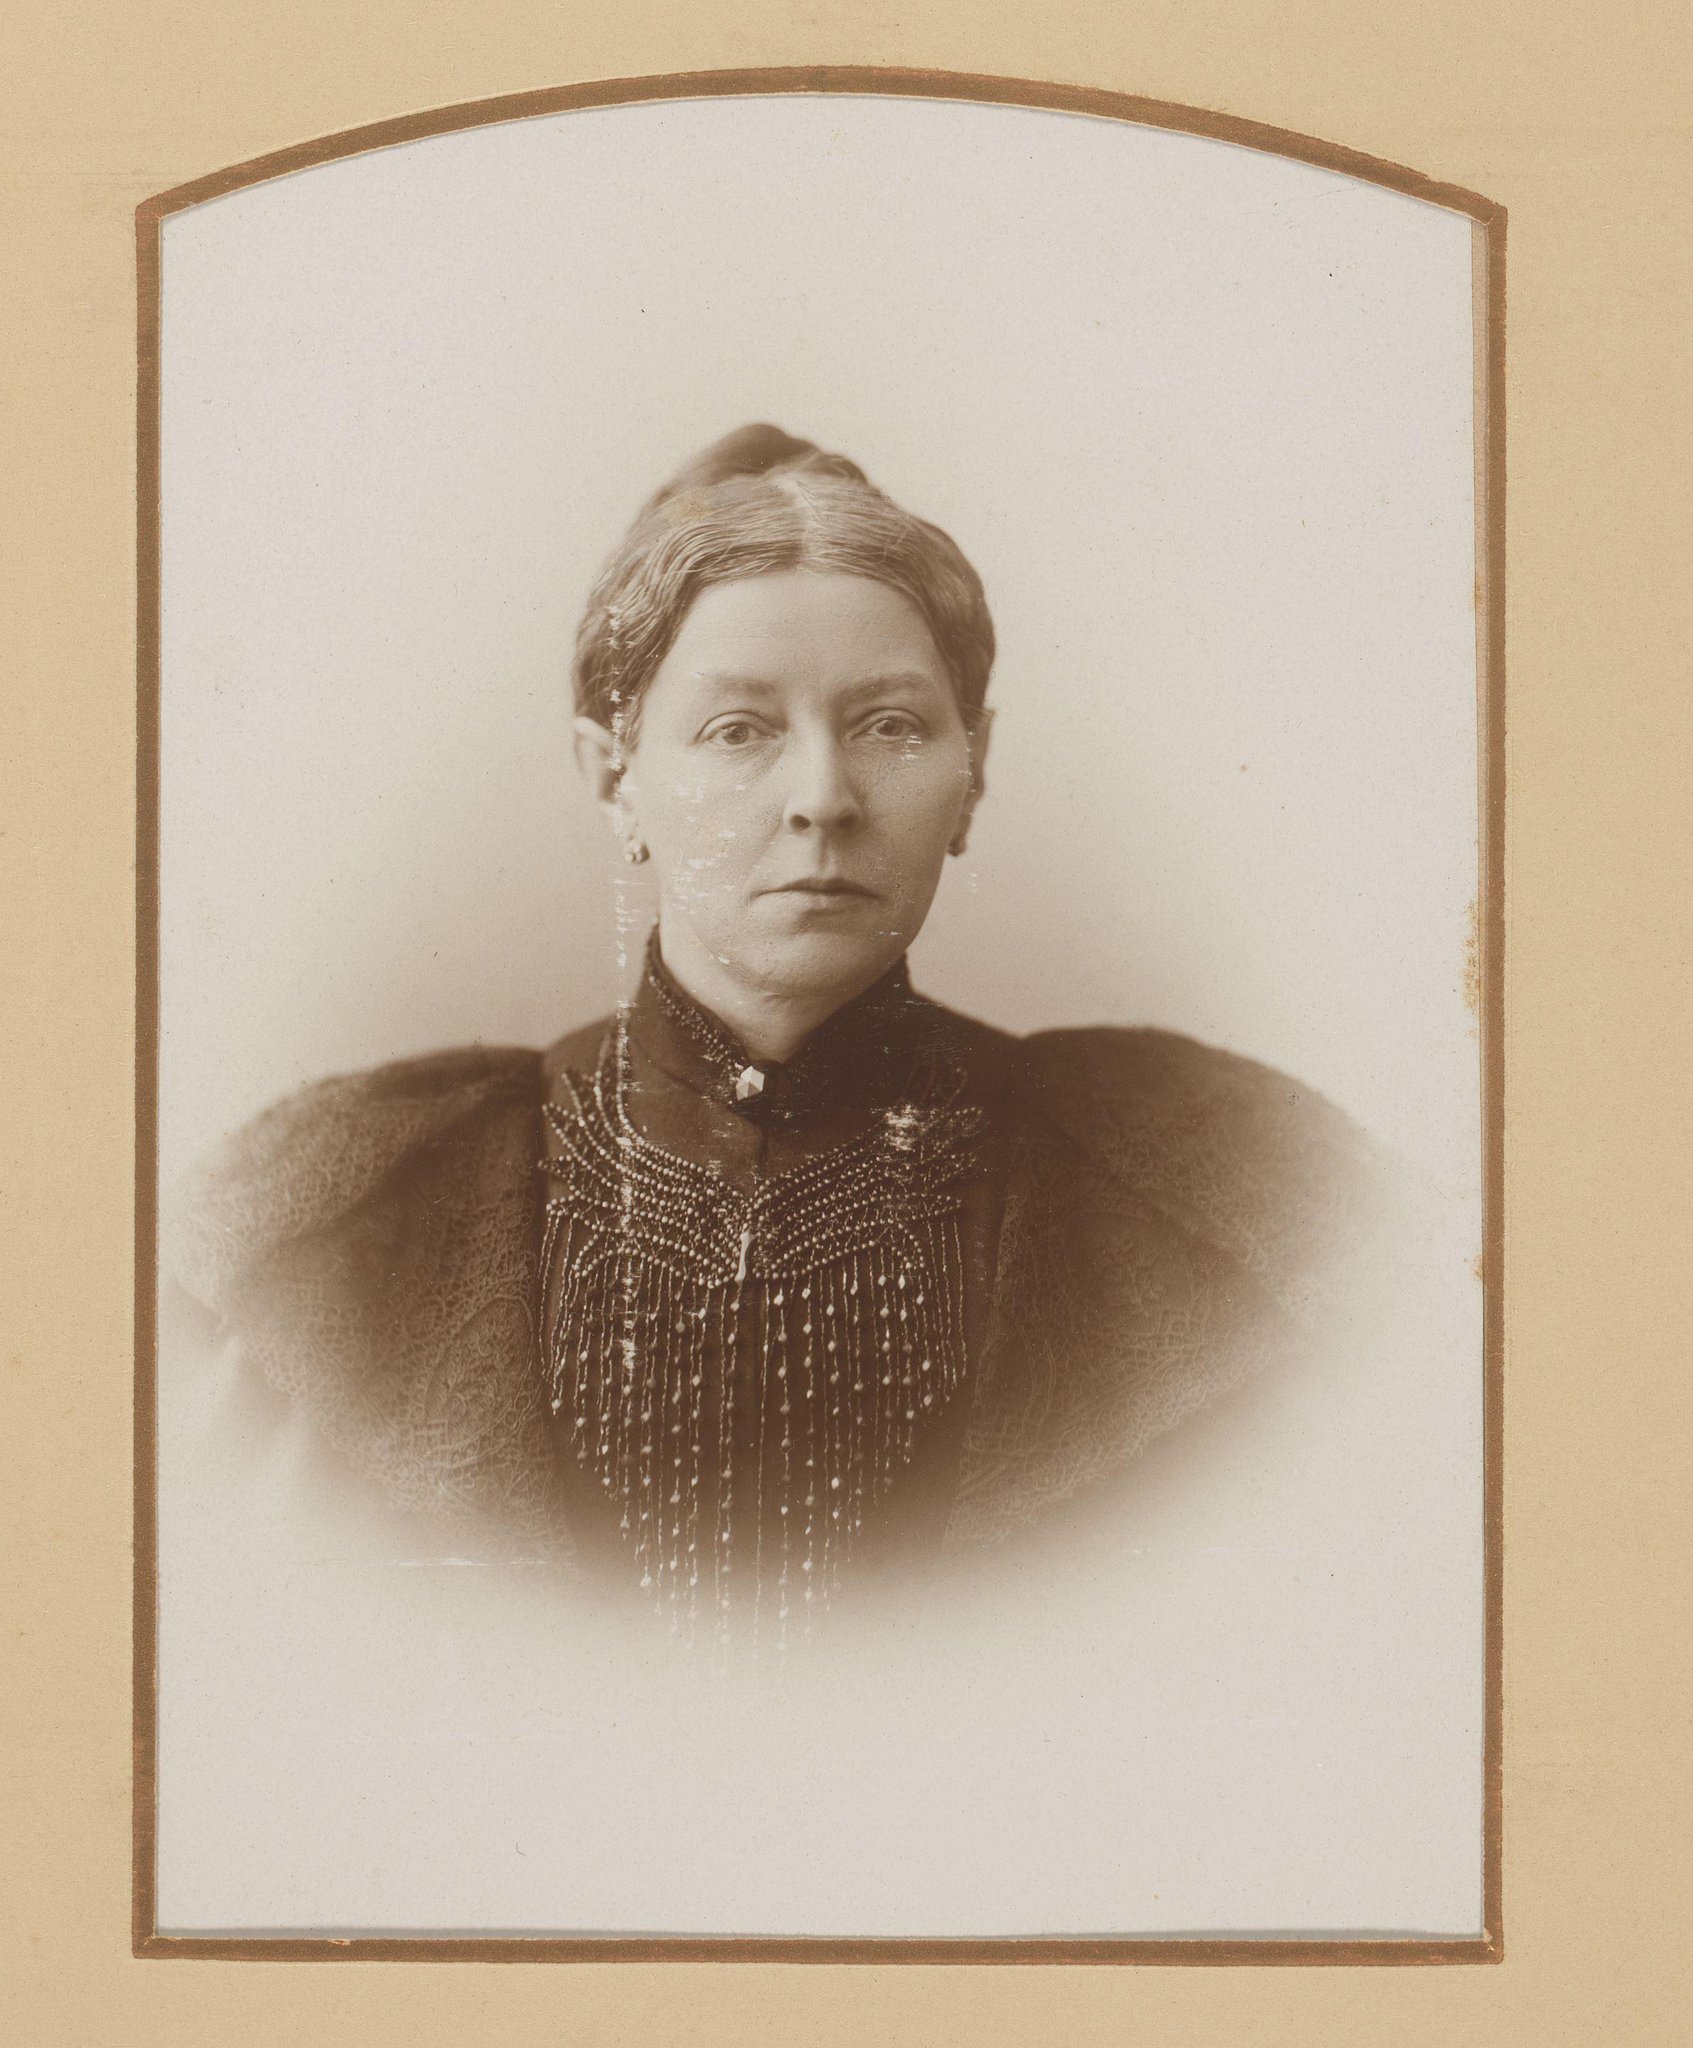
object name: cabinet photograph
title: Portret van een vrouw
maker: albert greiner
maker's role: fotograaf, fotostudio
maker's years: 1833-1890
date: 1874-1887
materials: cardboard, photographic support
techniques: collodion silver print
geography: amsterdam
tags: historical persons - bb - woman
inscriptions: inscription: ‘Albert Greiner/ Photograaf/ van/ wijlen z/m/ den/ koning willem III/ en h.m. de/ koningin weduwe/ Amsterdam/ Nieuwendijk 89./ Specialiteit in Vergrootingen.’